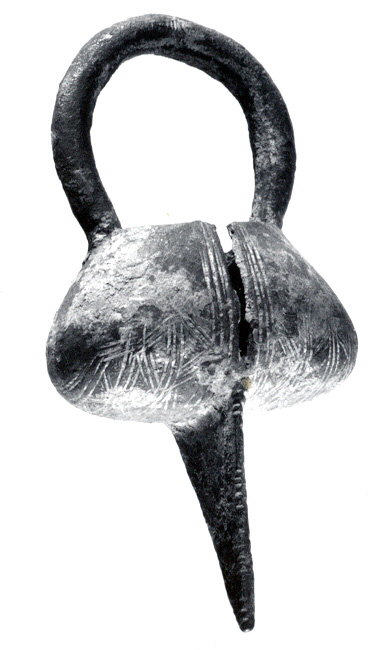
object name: ornament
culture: middle niger civilization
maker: middle niger artist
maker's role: artist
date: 801-1700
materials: copper alloy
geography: mali